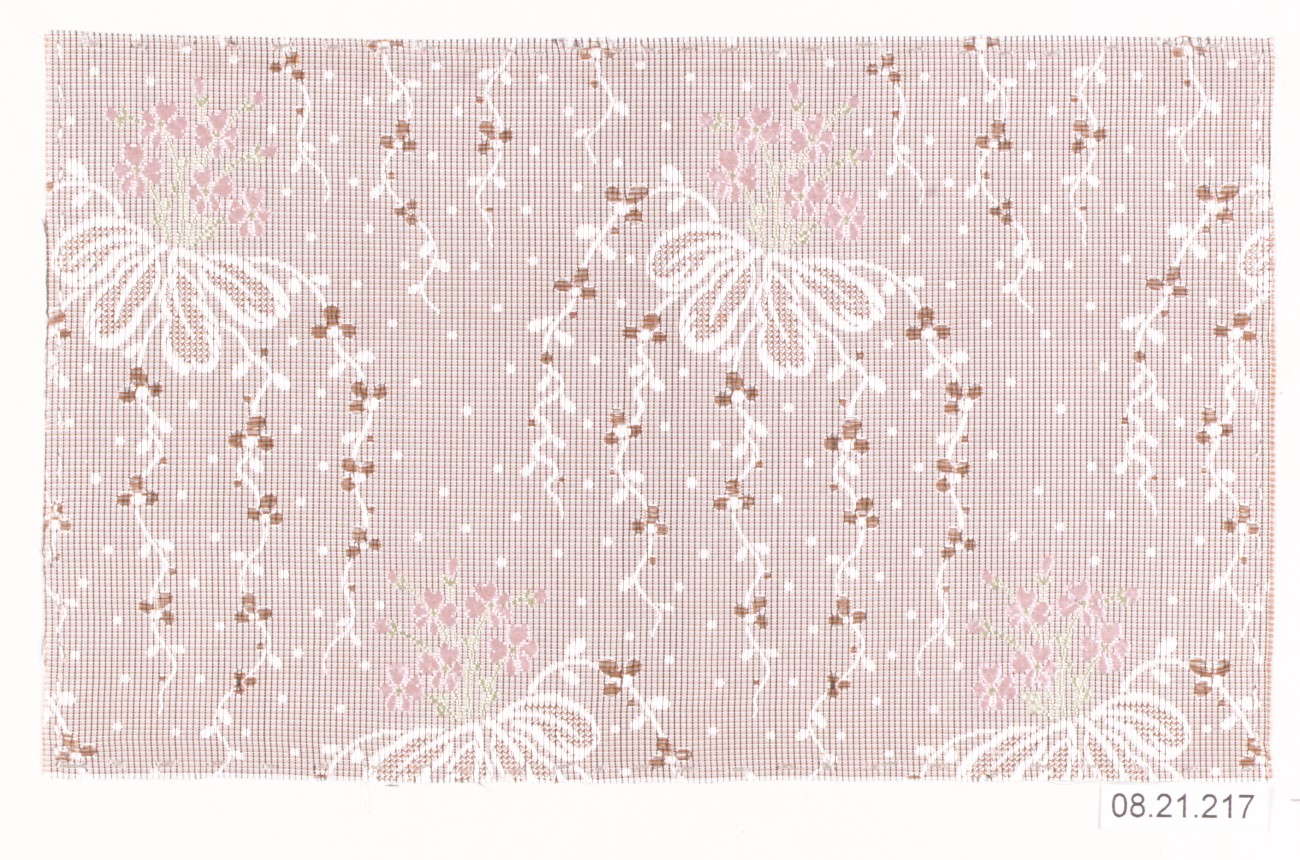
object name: textile sample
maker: Anonymous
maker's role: designer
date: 1900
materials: silk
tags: flowers